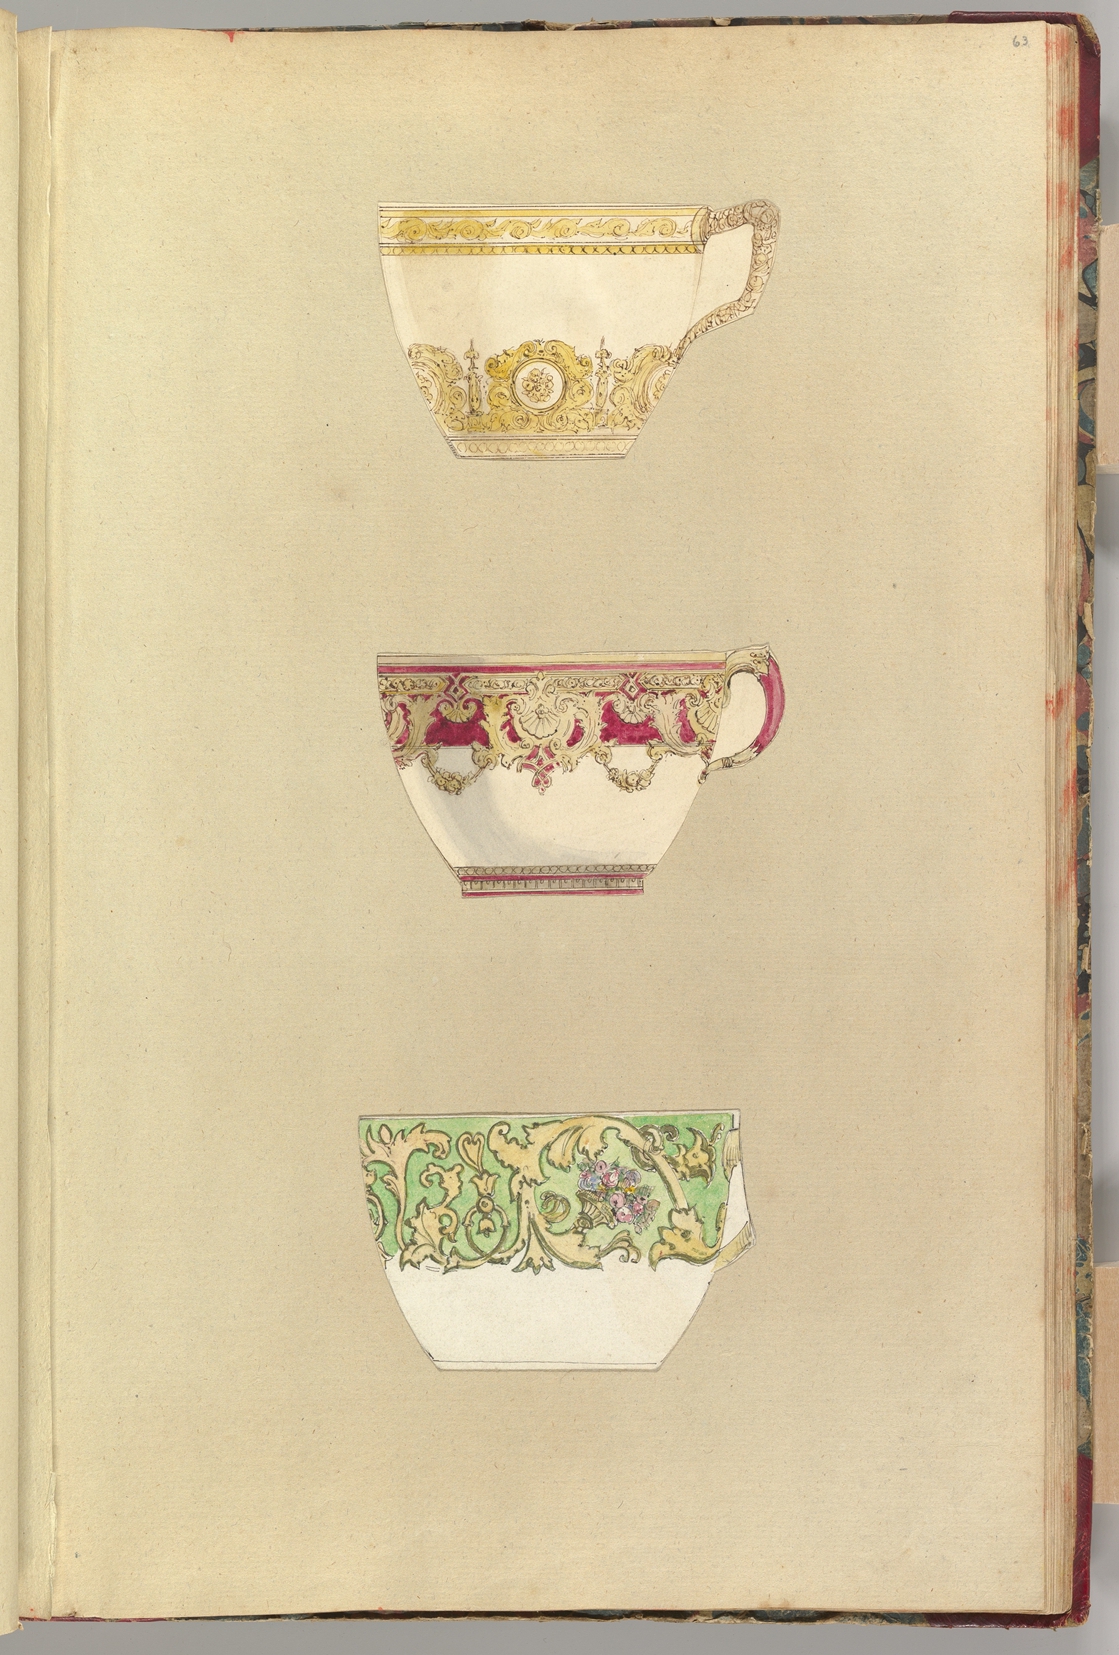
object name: drawing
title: Three Designs for Decorated Cups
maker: alfred henry forrester [alfred crowquill]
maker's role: artist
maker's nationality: british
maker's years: 1804-1872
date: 1845-1855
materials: ink, watercolor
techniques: pen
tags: cups